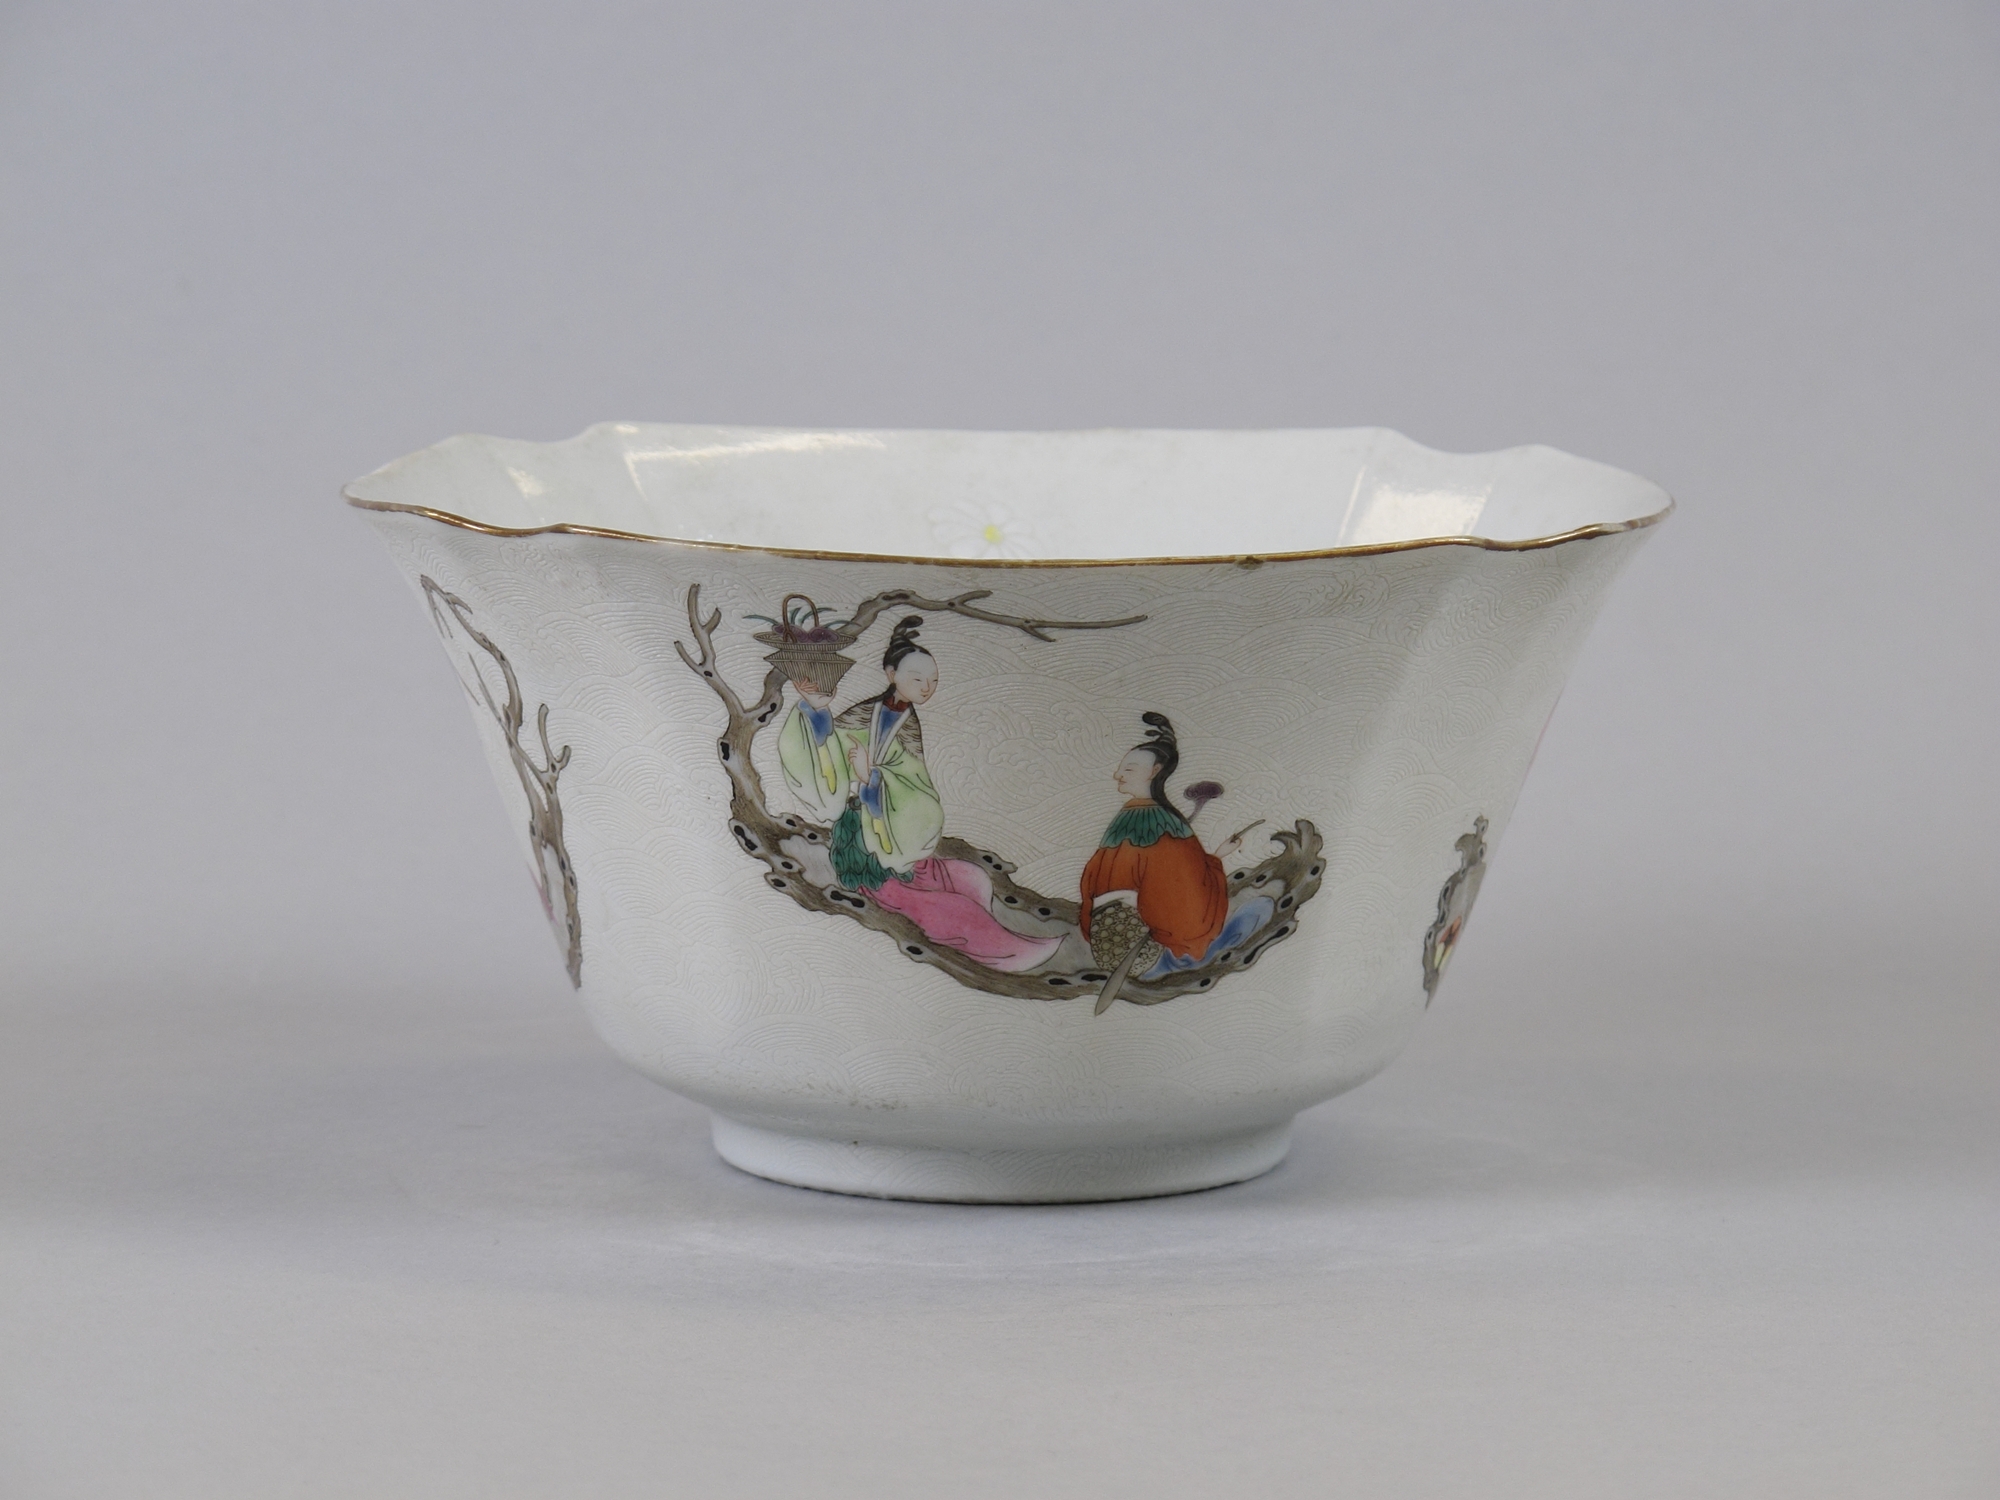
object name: bowl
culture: chinese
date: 1796-1820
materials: enamel, porcelain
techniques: engraving, overglaze, painting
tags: men,women